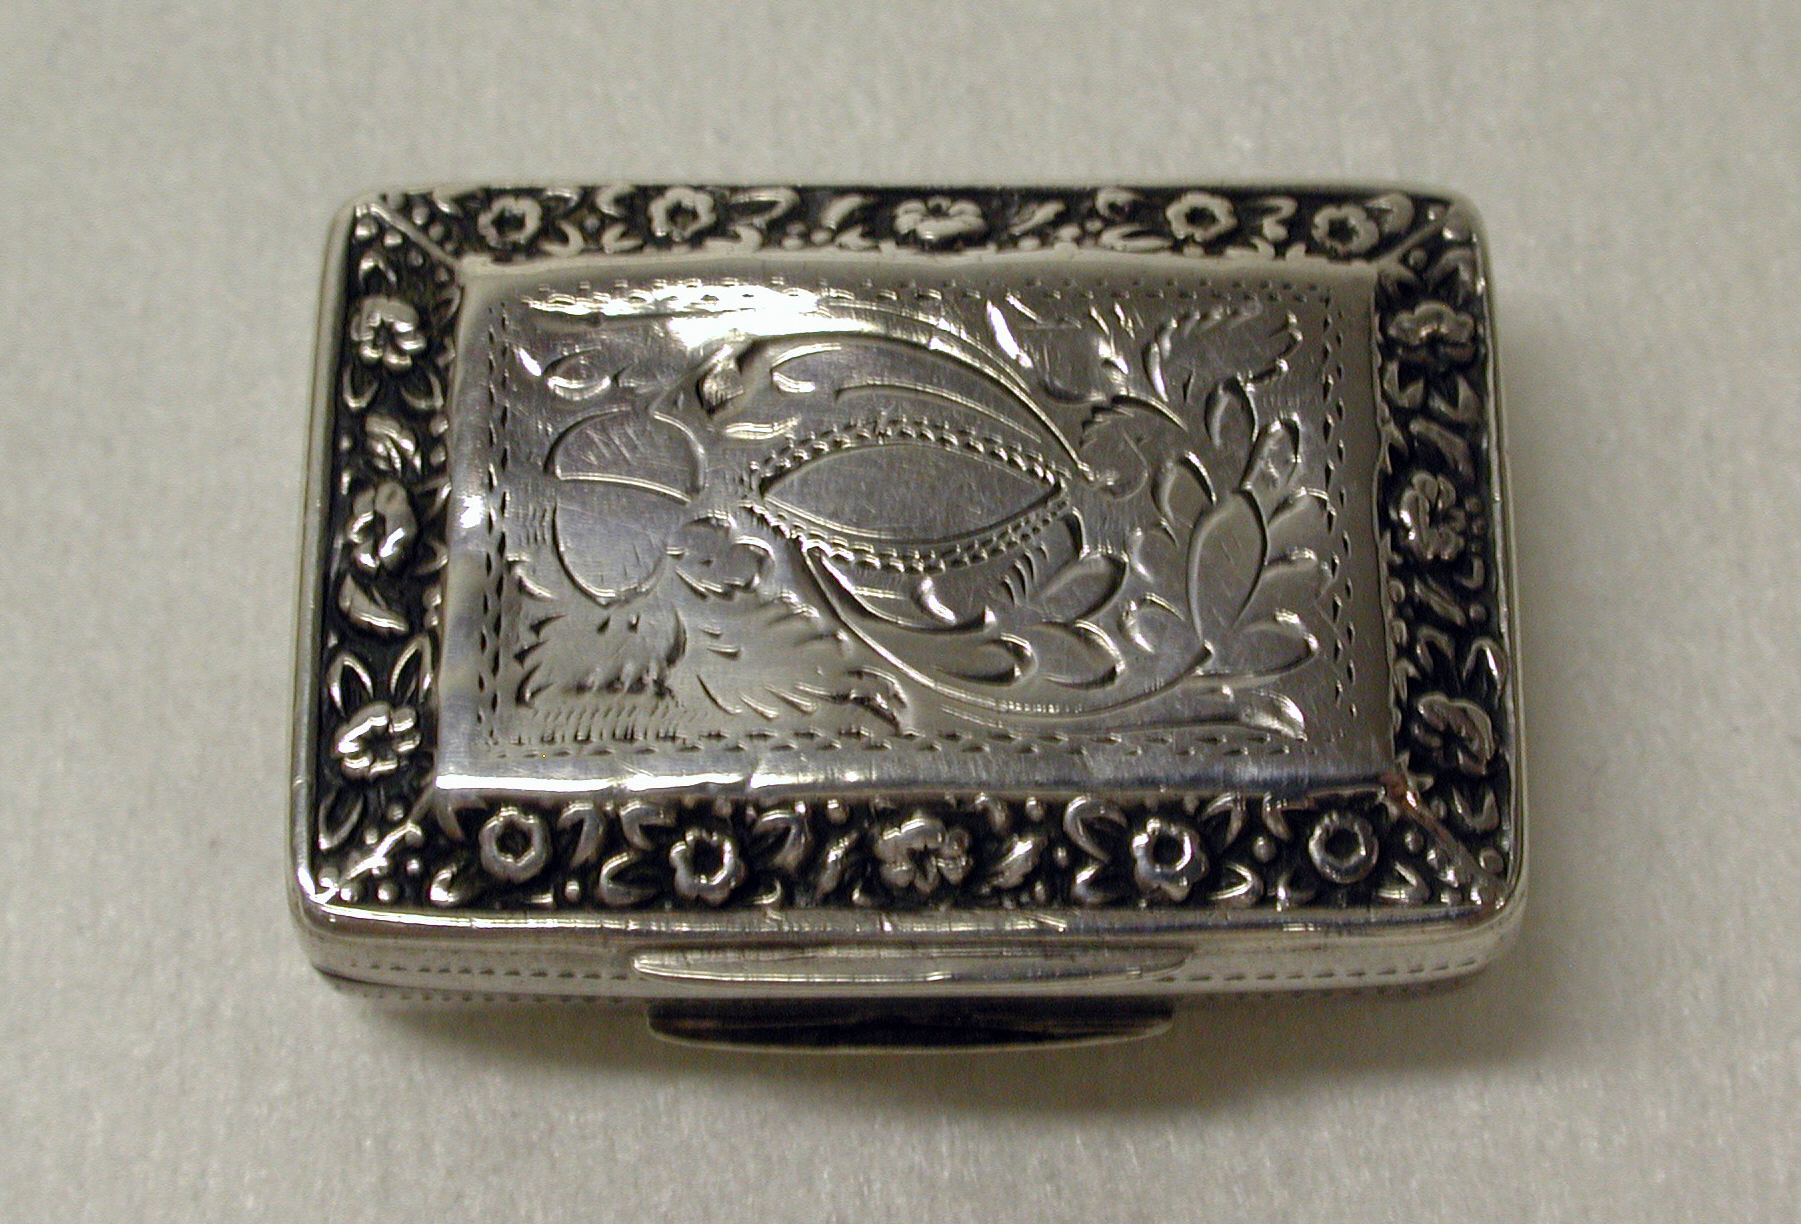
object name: vinaigrette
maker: john bettridge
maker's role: maker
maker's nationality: british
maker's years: 1817-1835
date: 1824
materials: silver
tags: flowers